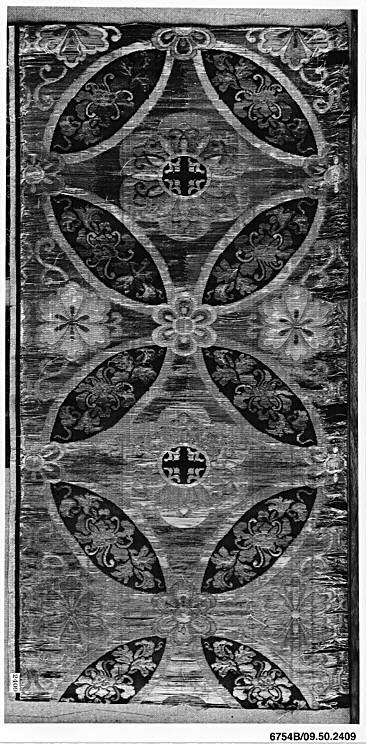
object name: piece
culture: japanese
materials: metal thread, silk